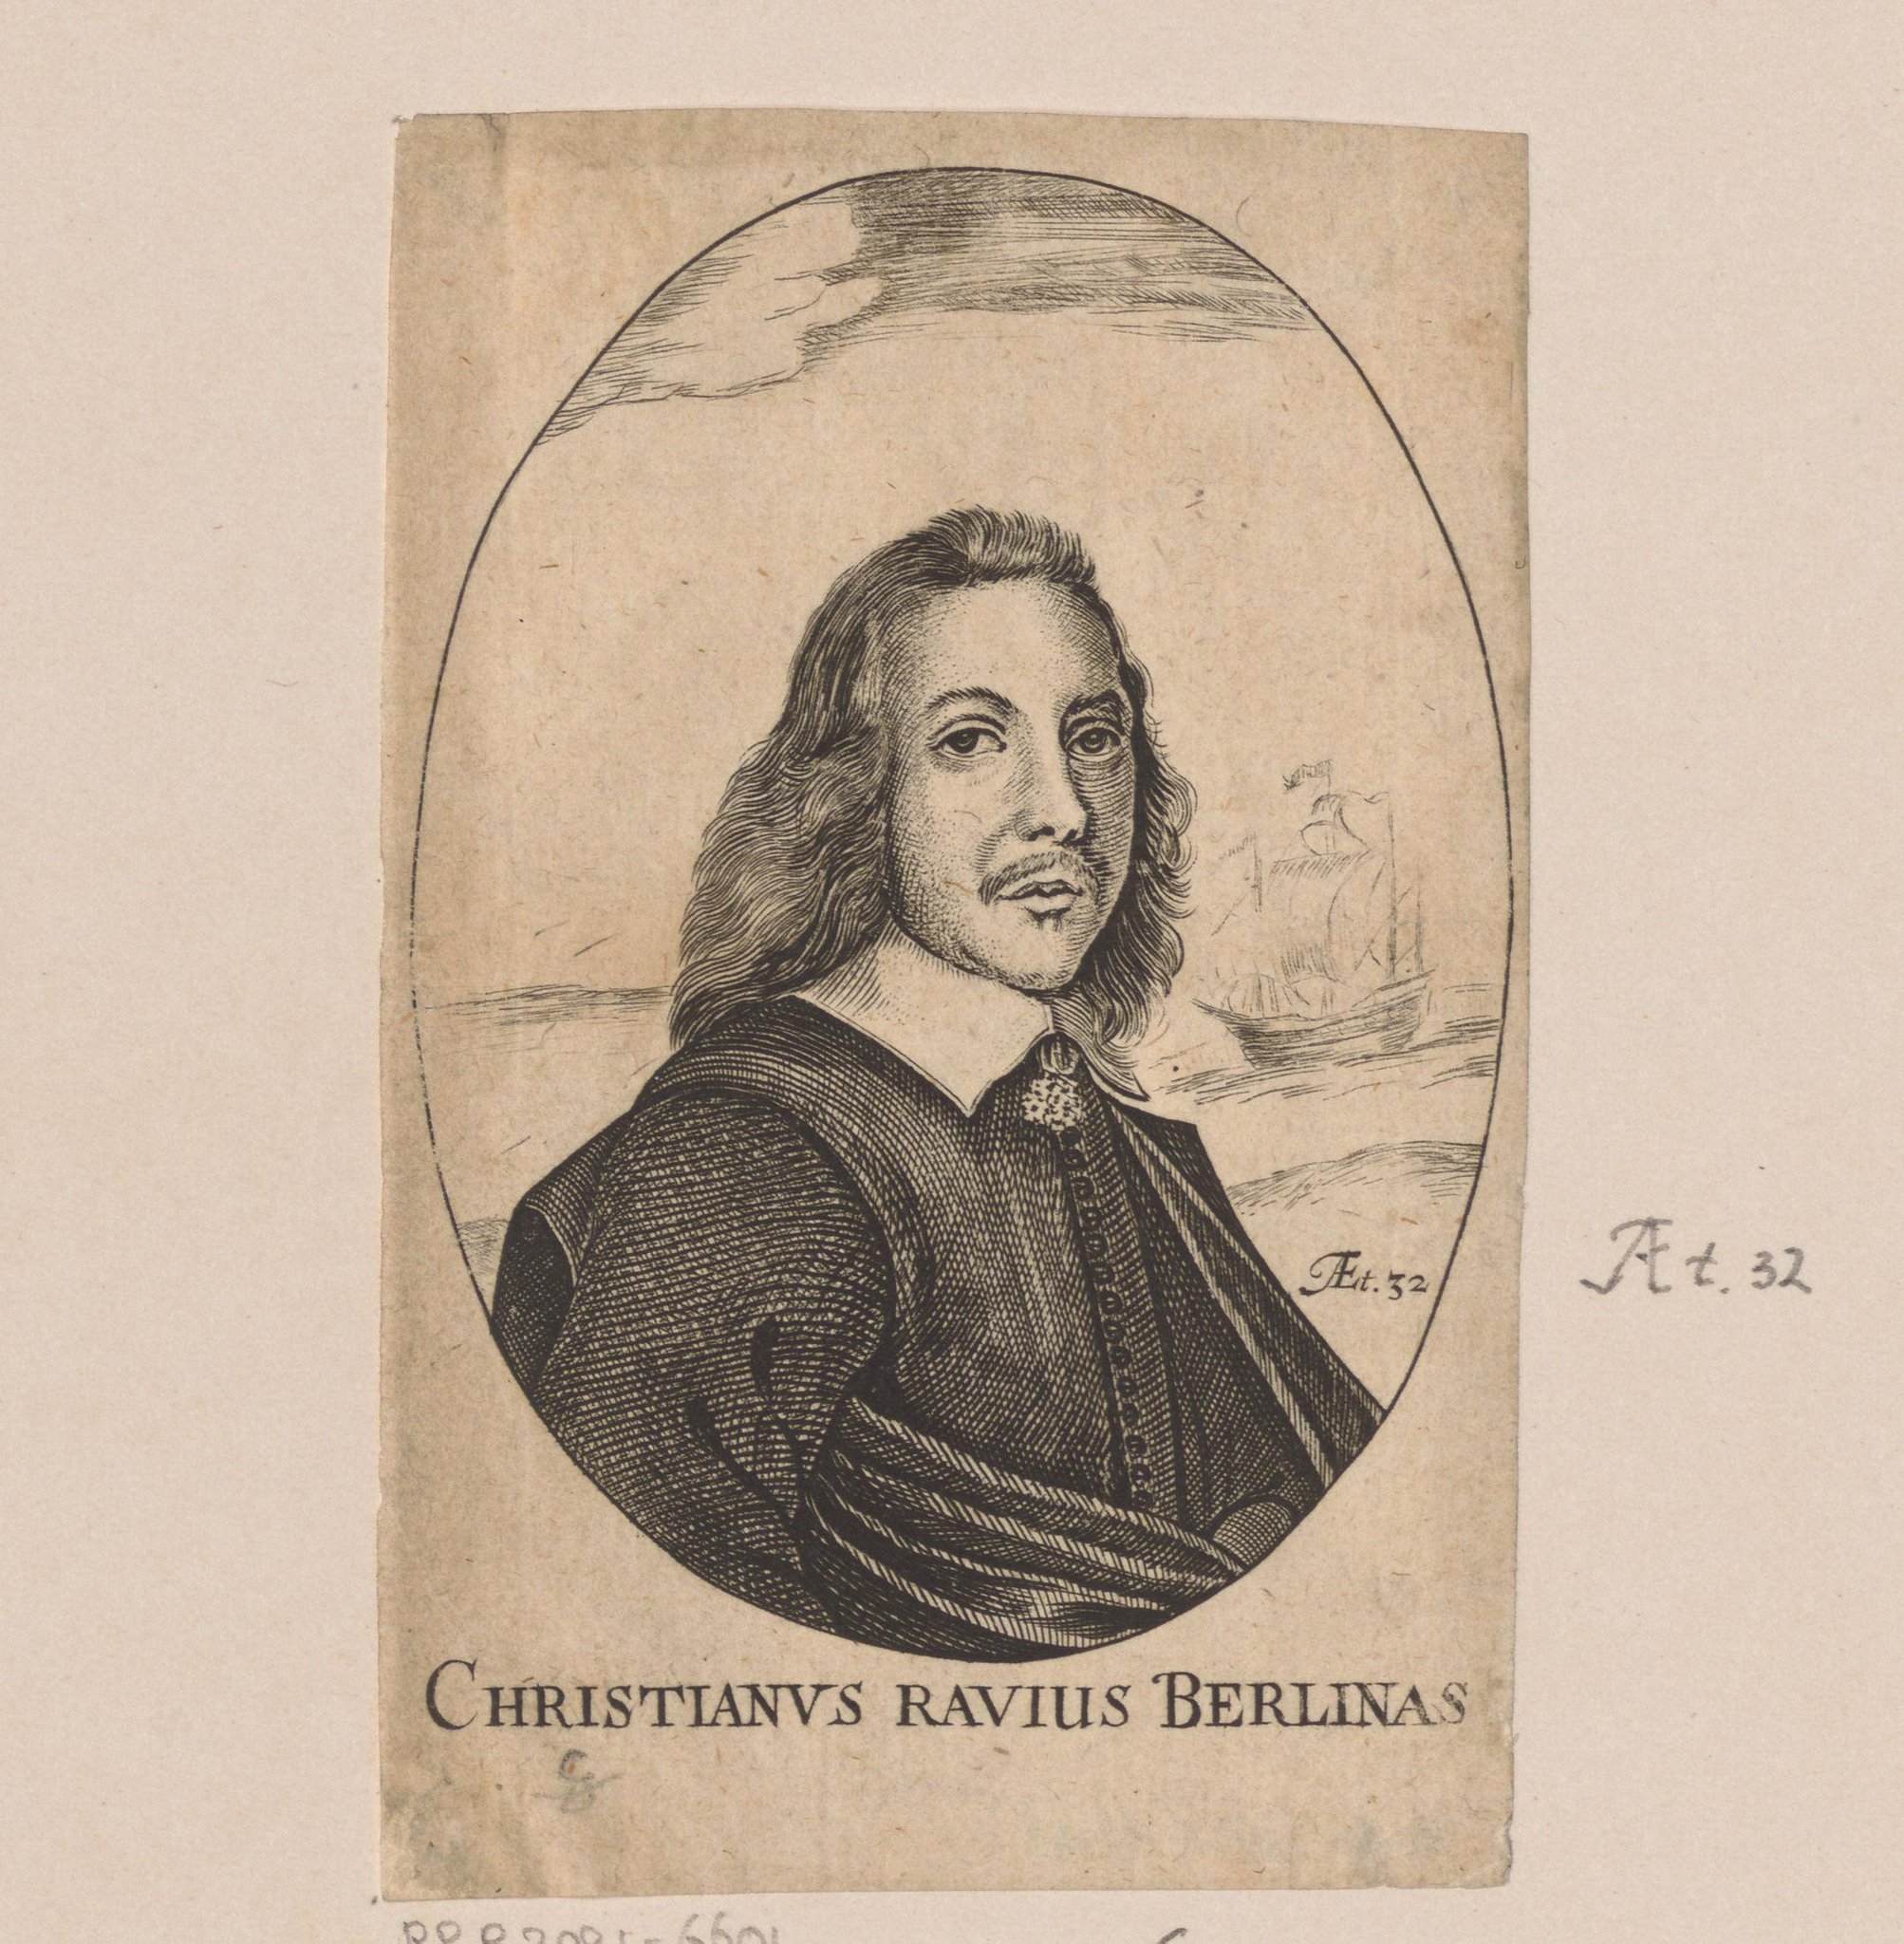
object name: print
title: Portret van Christian Ravis op 32-jarige leeftijd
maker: Anonymous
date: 1645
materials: paper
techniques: engraving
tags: historical persons